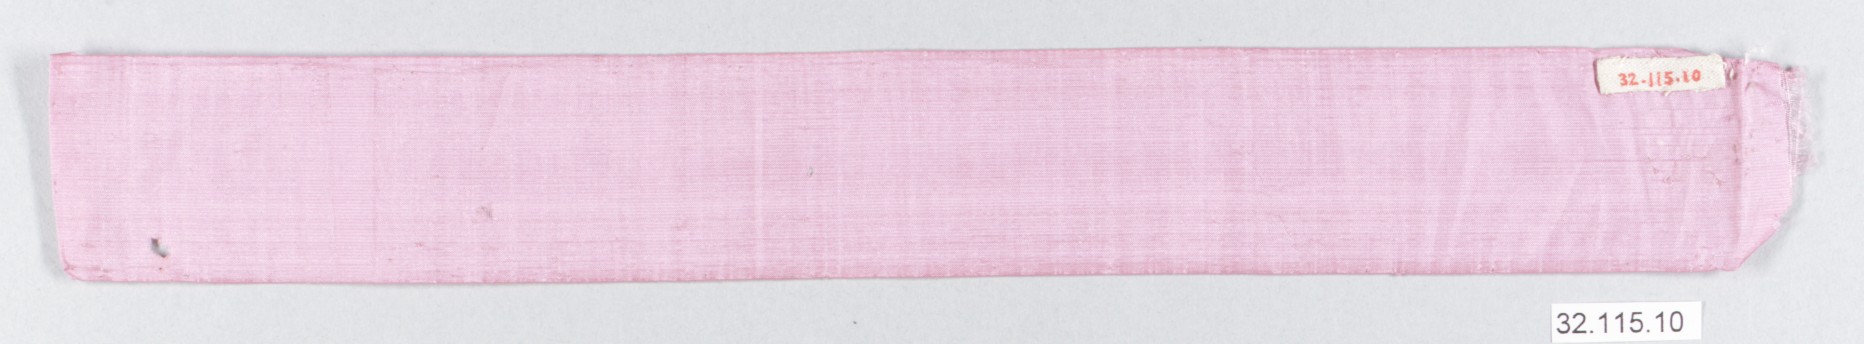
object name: ribbon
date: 1860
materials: silk